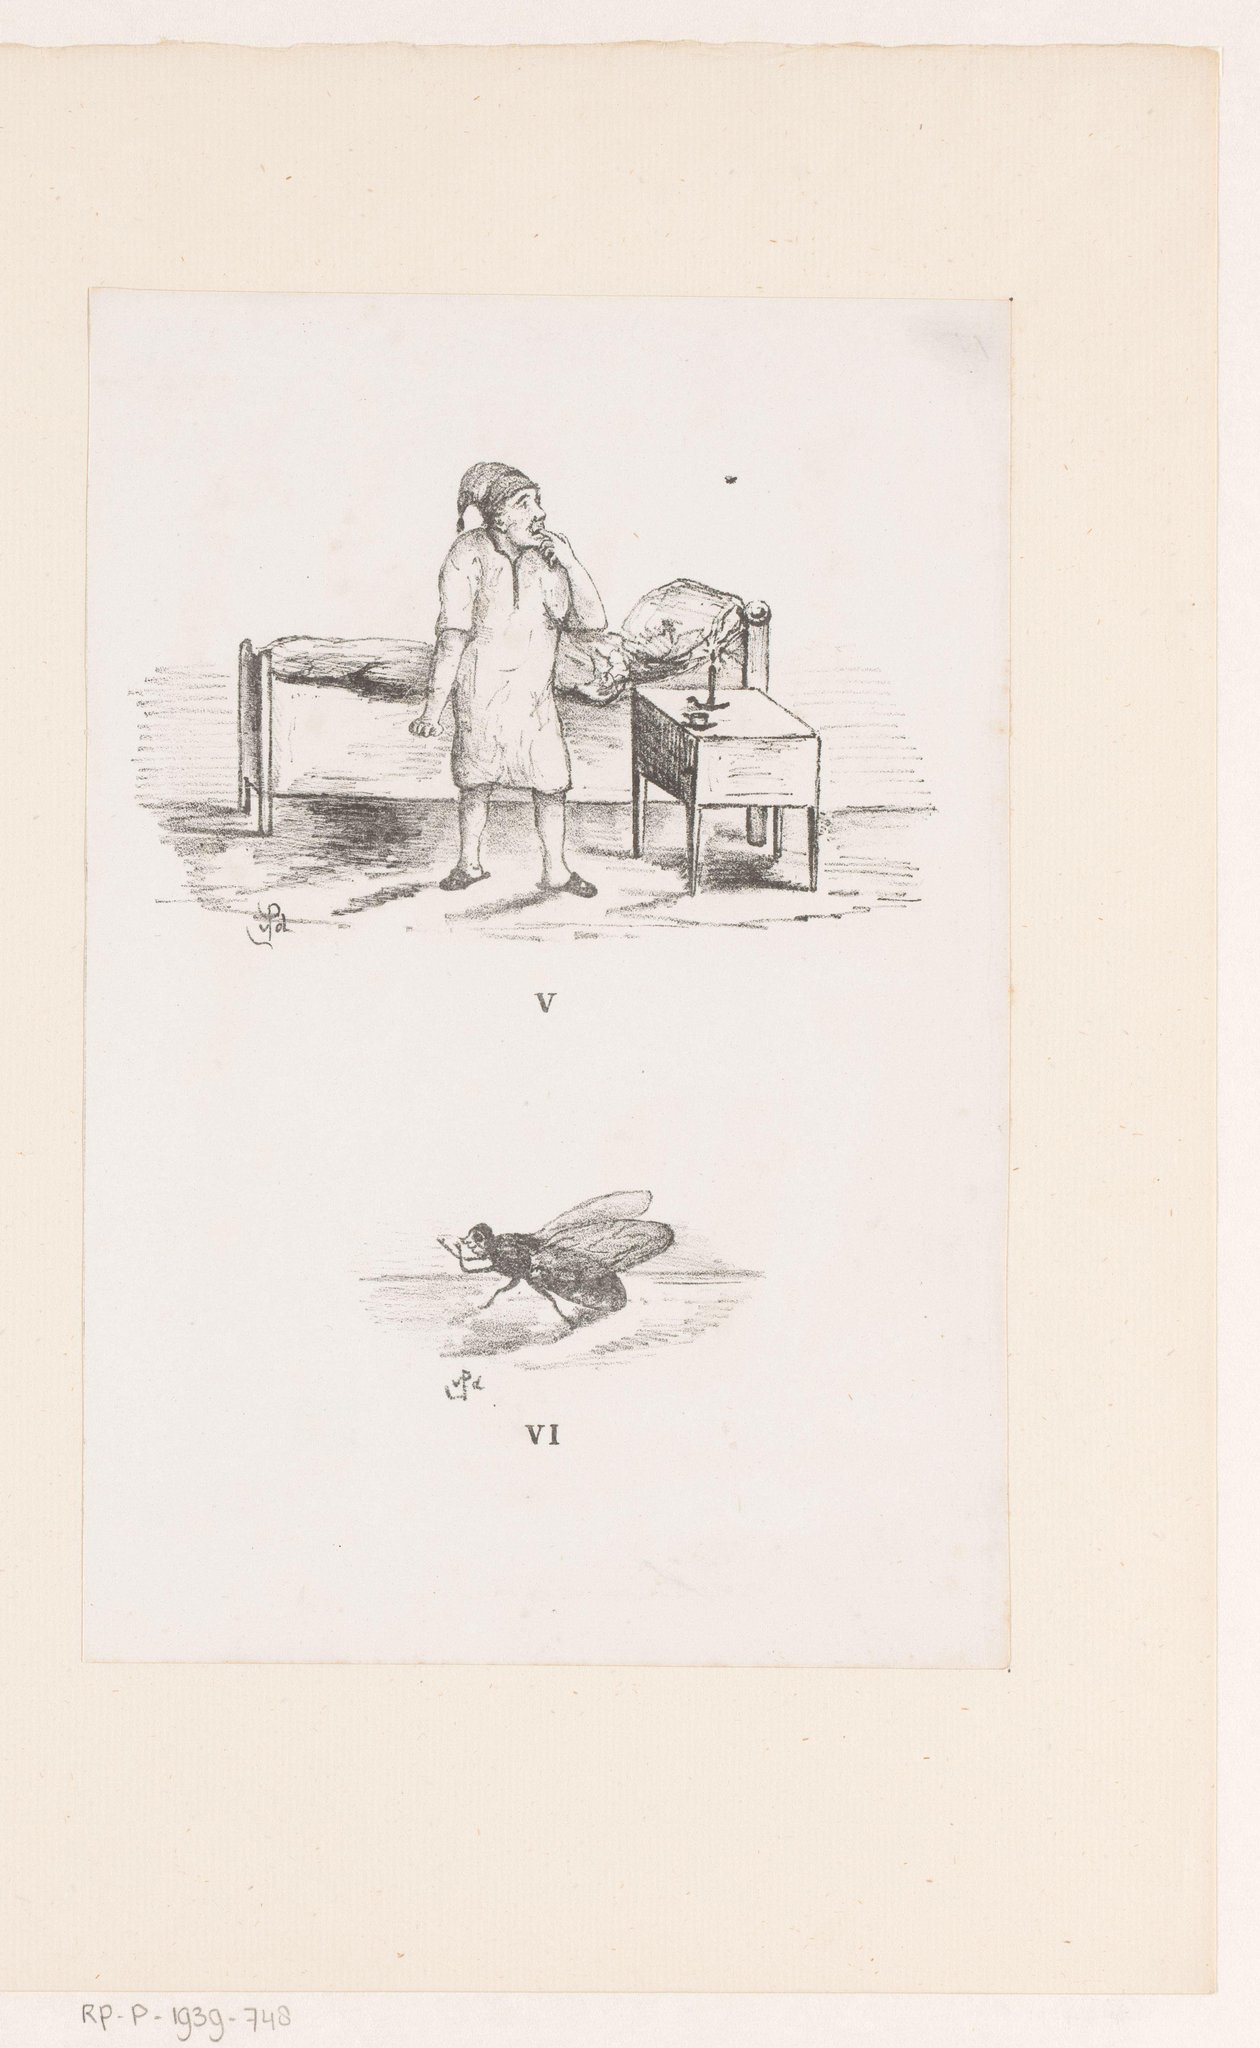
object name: print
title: Man probeert vlieg te vangen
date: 1864-1902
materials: paper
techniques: lithograph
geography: netherlands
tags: hunting, chase, insects: fly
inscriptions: collector's mark: Lugt 2760, collector's mark: Lugt 2166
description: Twee scènes op een blad. Een man loopt voorzichtig met zijn slaapmuts in zijn handen richting een kopje waarop een vlieg zit. Hij heeft de vlieg gevangen en houdt hem tussen zijn vingers. Genummerd III en IV.